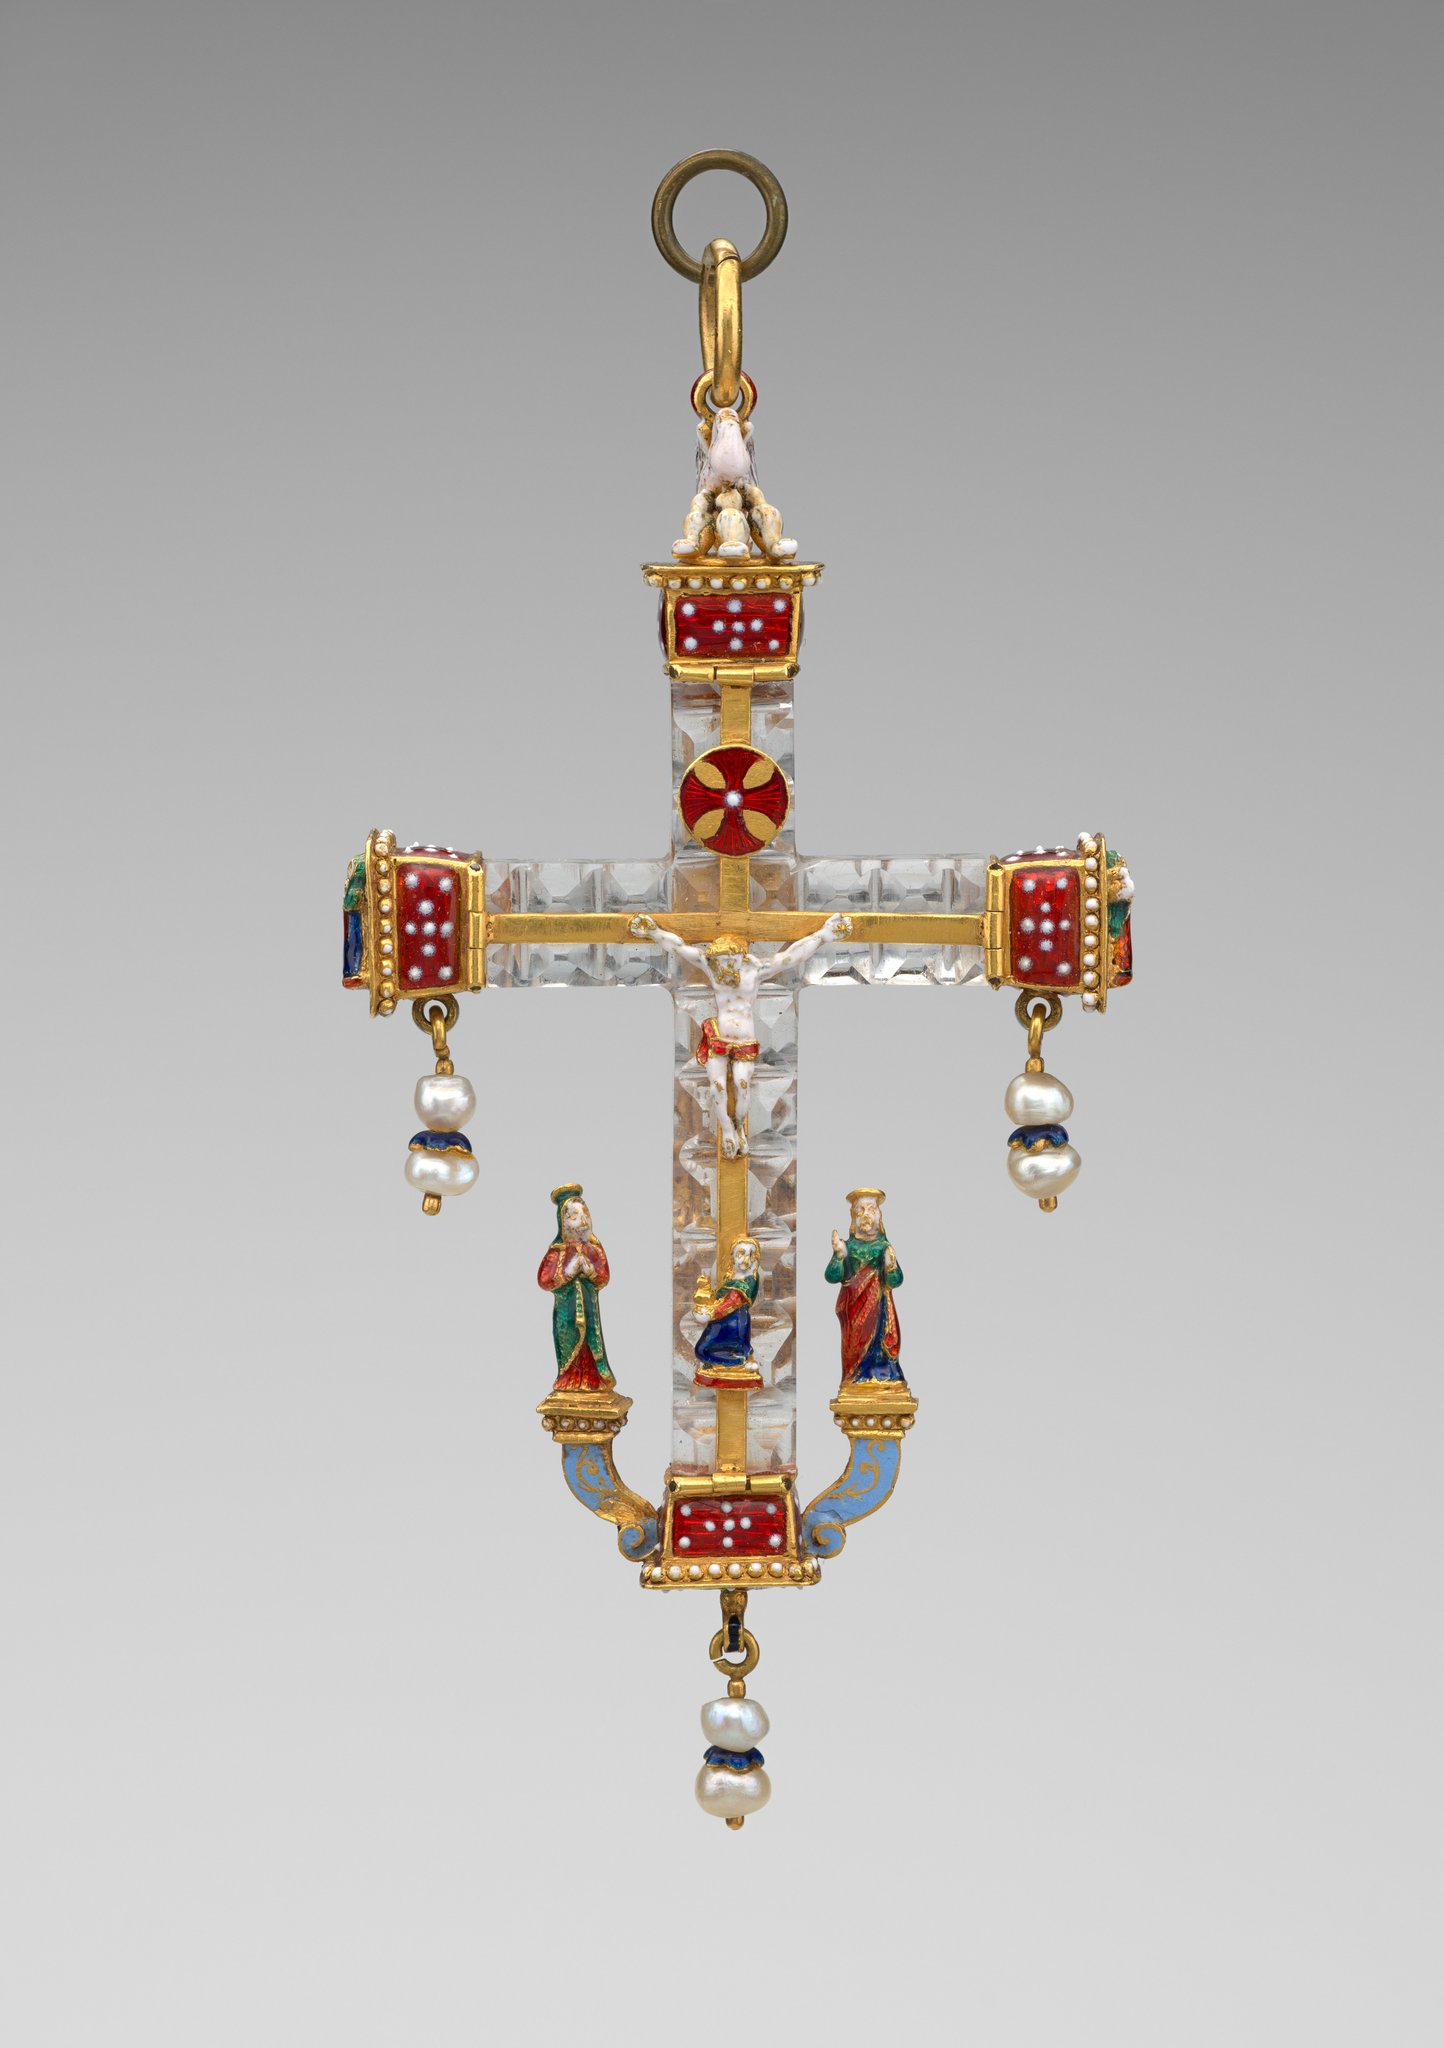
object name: pendant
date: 1501-1600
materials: crystal, enamel, gold, pearl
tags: christ,cross,crucifixion